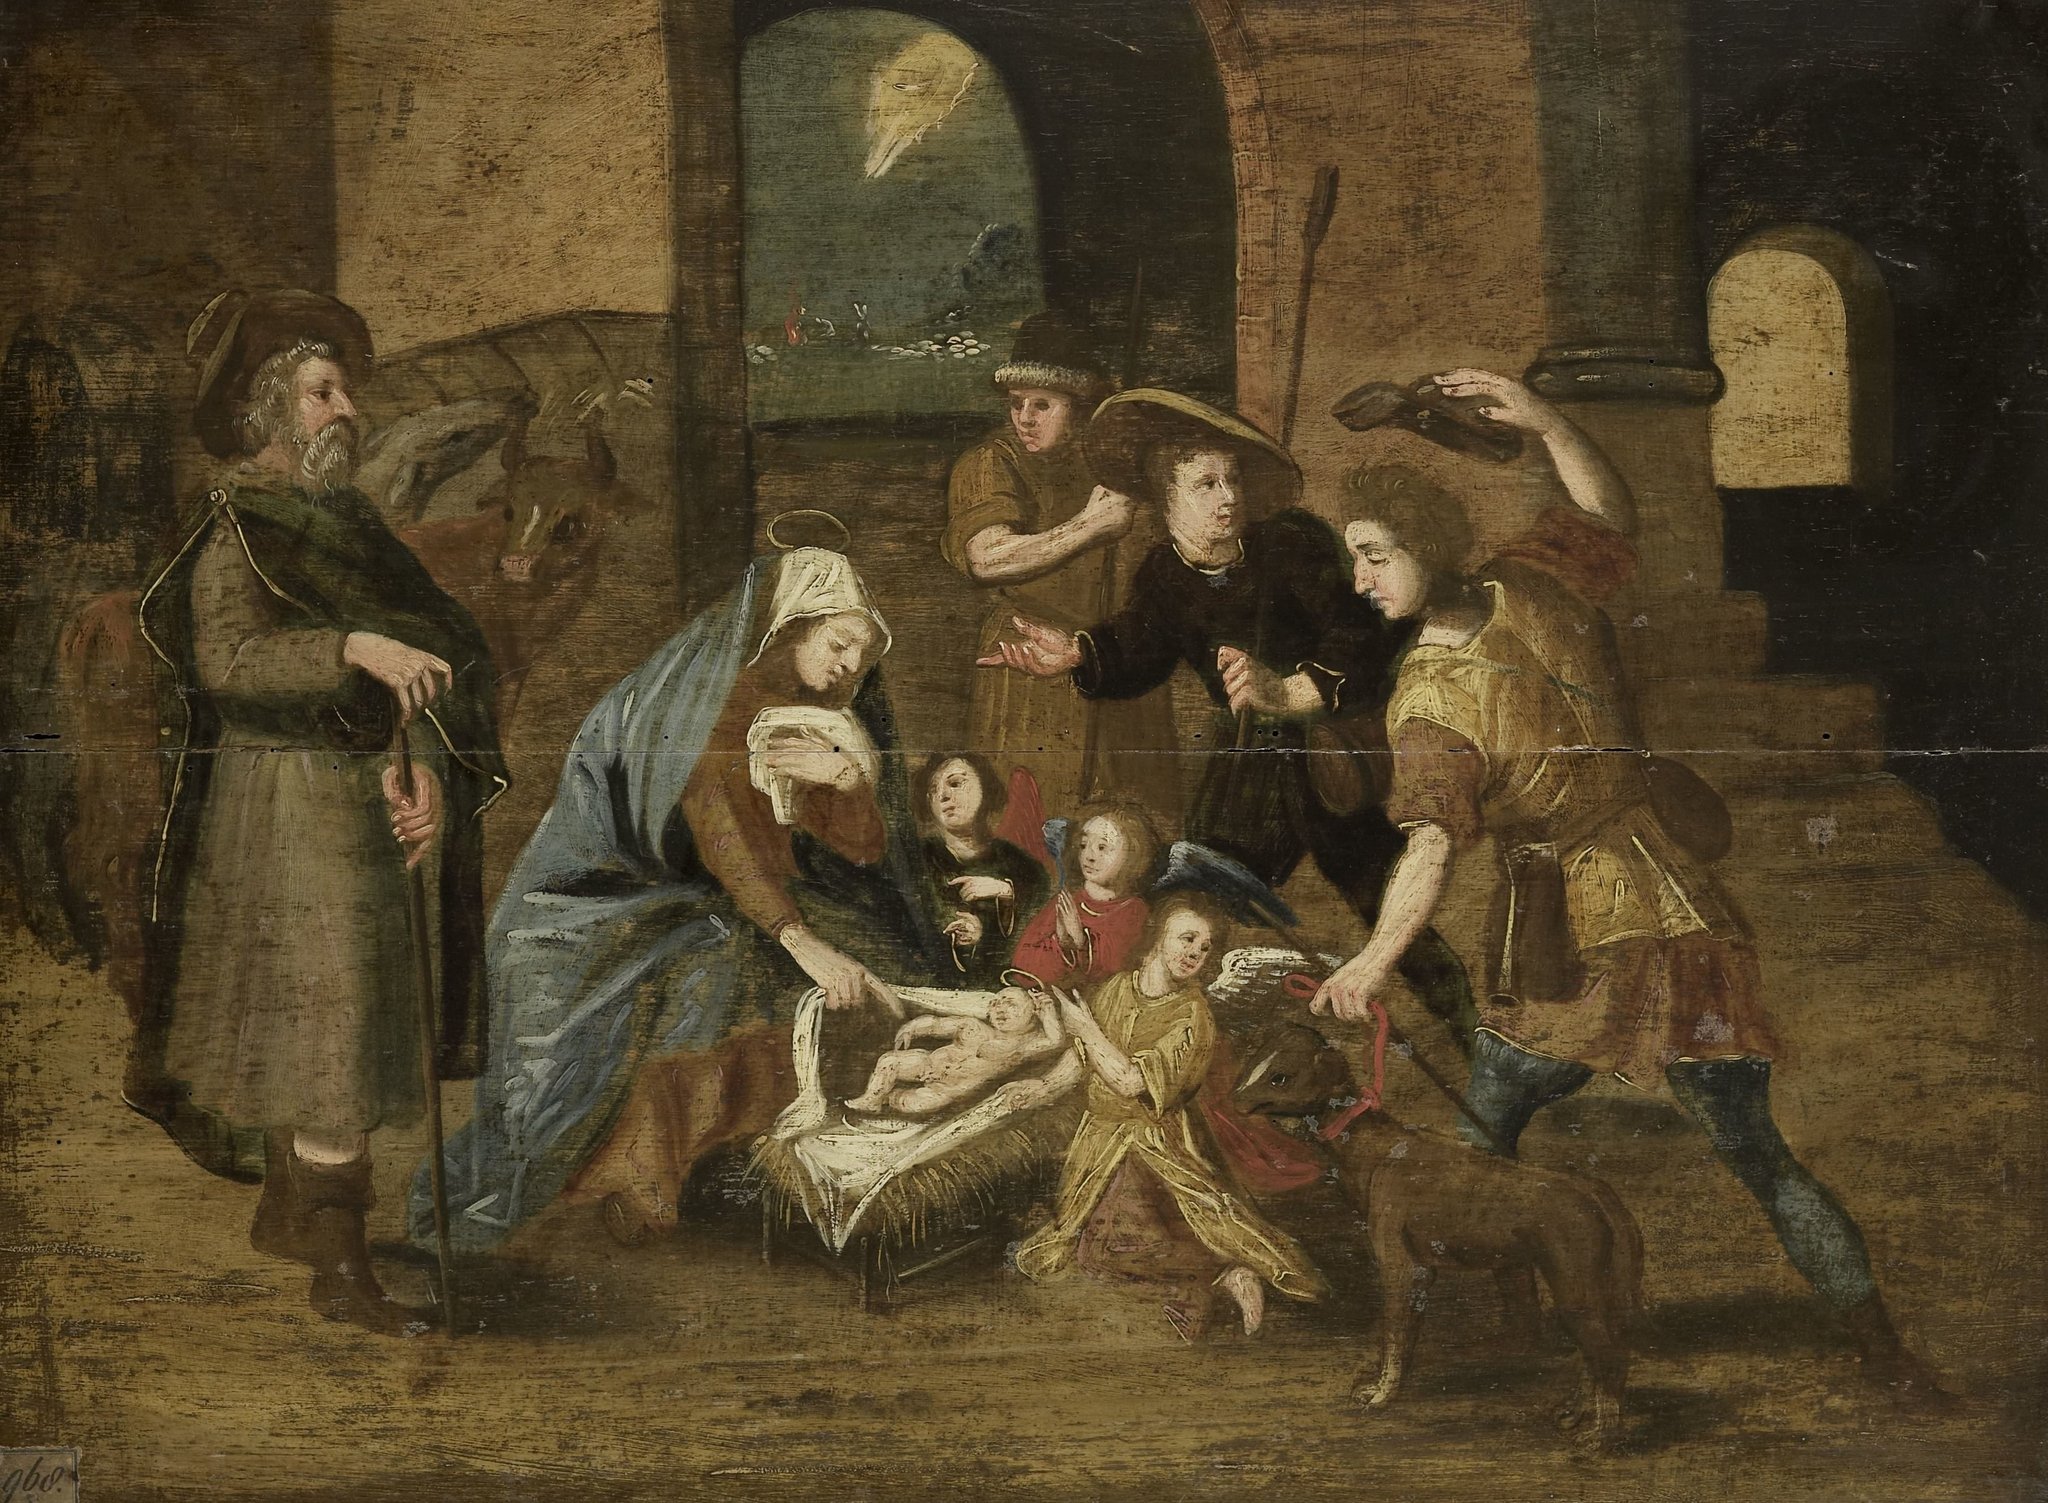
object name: painting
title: The Adoration of the Shepherds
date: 1580-1699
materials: oil, panel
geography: southern netherlands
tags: adoration of the christ-child by the shepherds; mary and joseph present (+ angel(s))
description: De aanbidding der herders. Herders en engelen verzameld rond de heilige familie met het kind in de kribbe. Kopie naar een gravure van Jan Baptist Collaert I naar Maerten de Vos.